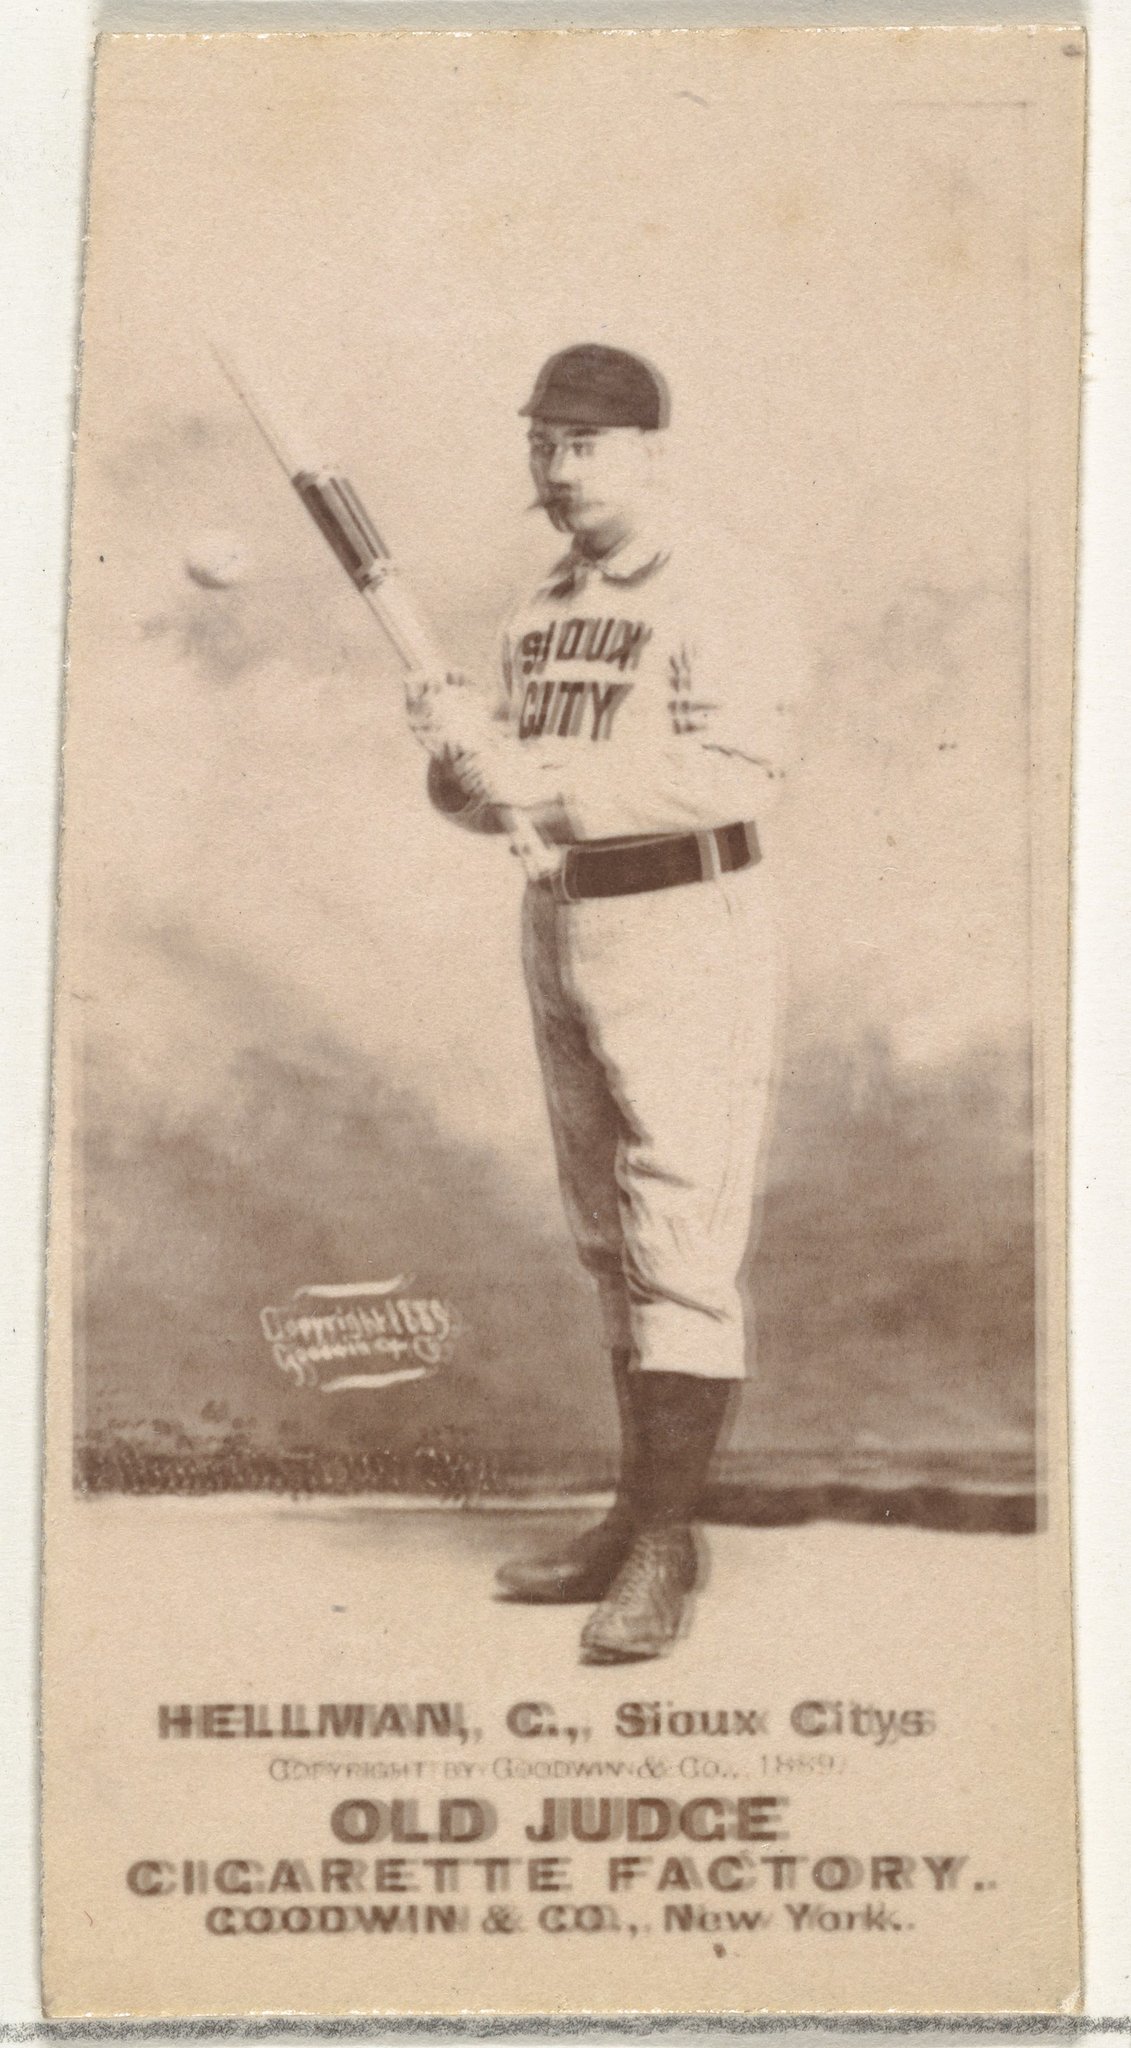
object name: baseball card, photograph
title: Anthony Joseph "Tony" Hellman, Catcher, Sioux City Corn Huskers, from the Old Judge series (N172) for Old Judge Cigarettes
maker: goodwin & company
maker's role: publisher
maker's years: 1850-1950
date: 1889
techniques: albumen silver print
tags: men,portraits,baseball,athletes